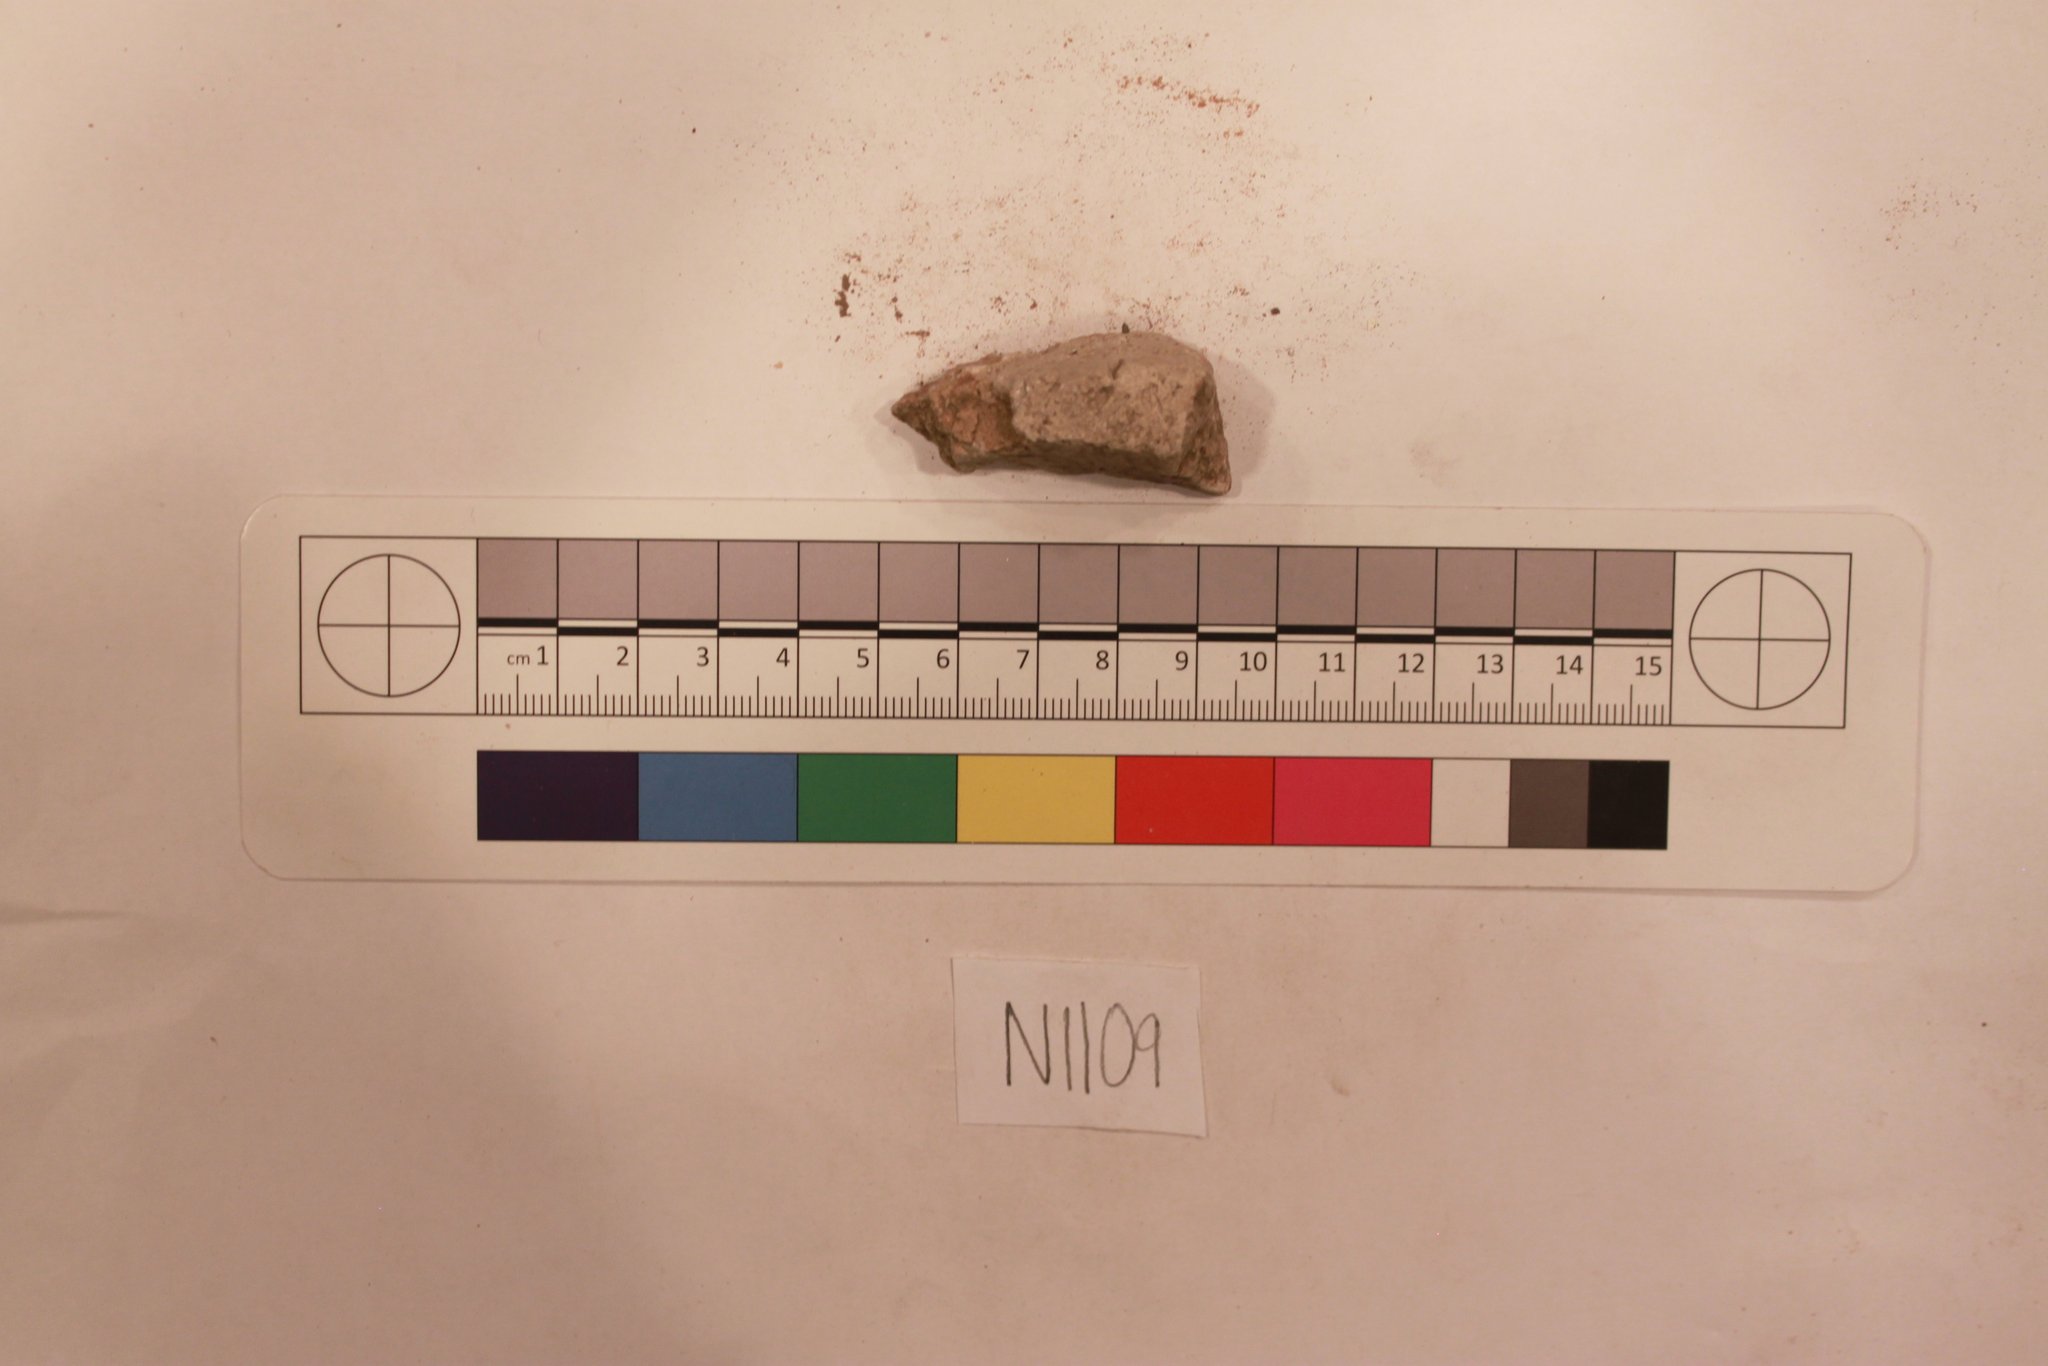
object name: fragment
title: Stucco Fragment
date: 701-1200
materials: plaster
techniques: carving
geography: iran